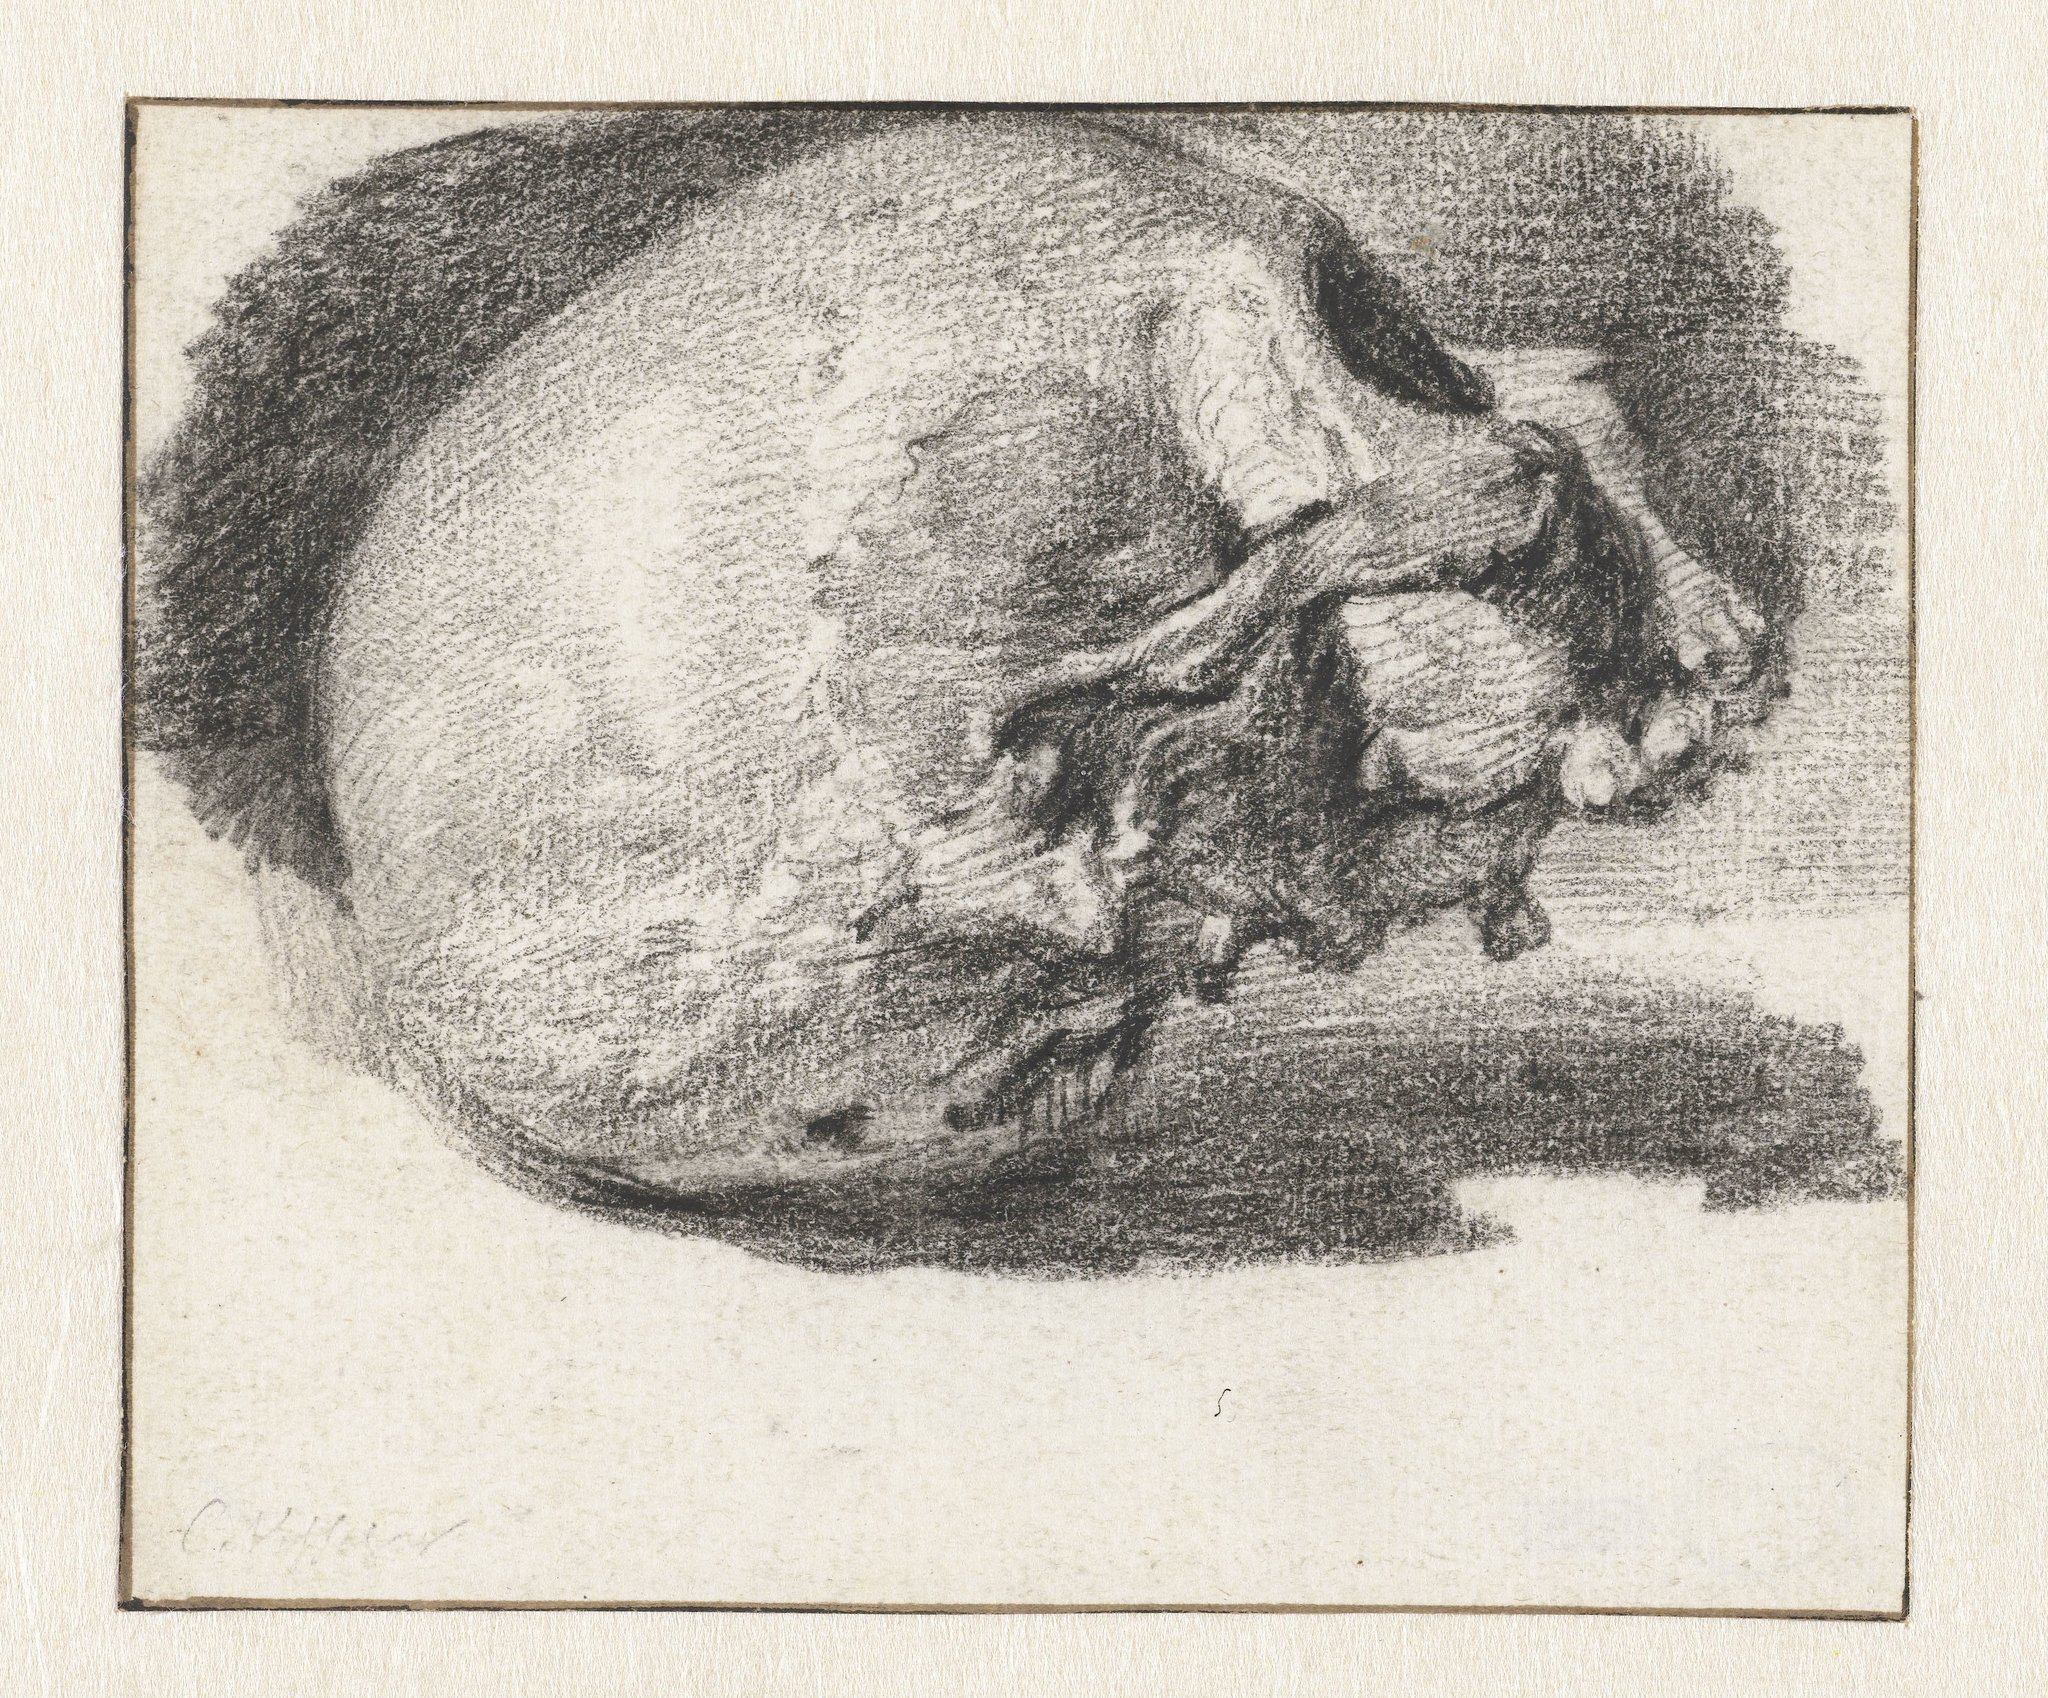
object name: drawing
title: Study of a Skull, Facing Right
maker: cornelis visscher (ii)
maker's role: draughtsman, painter, print maker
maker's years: 1628-1658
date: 1654-1658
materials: chalk, paper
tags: (human) skull